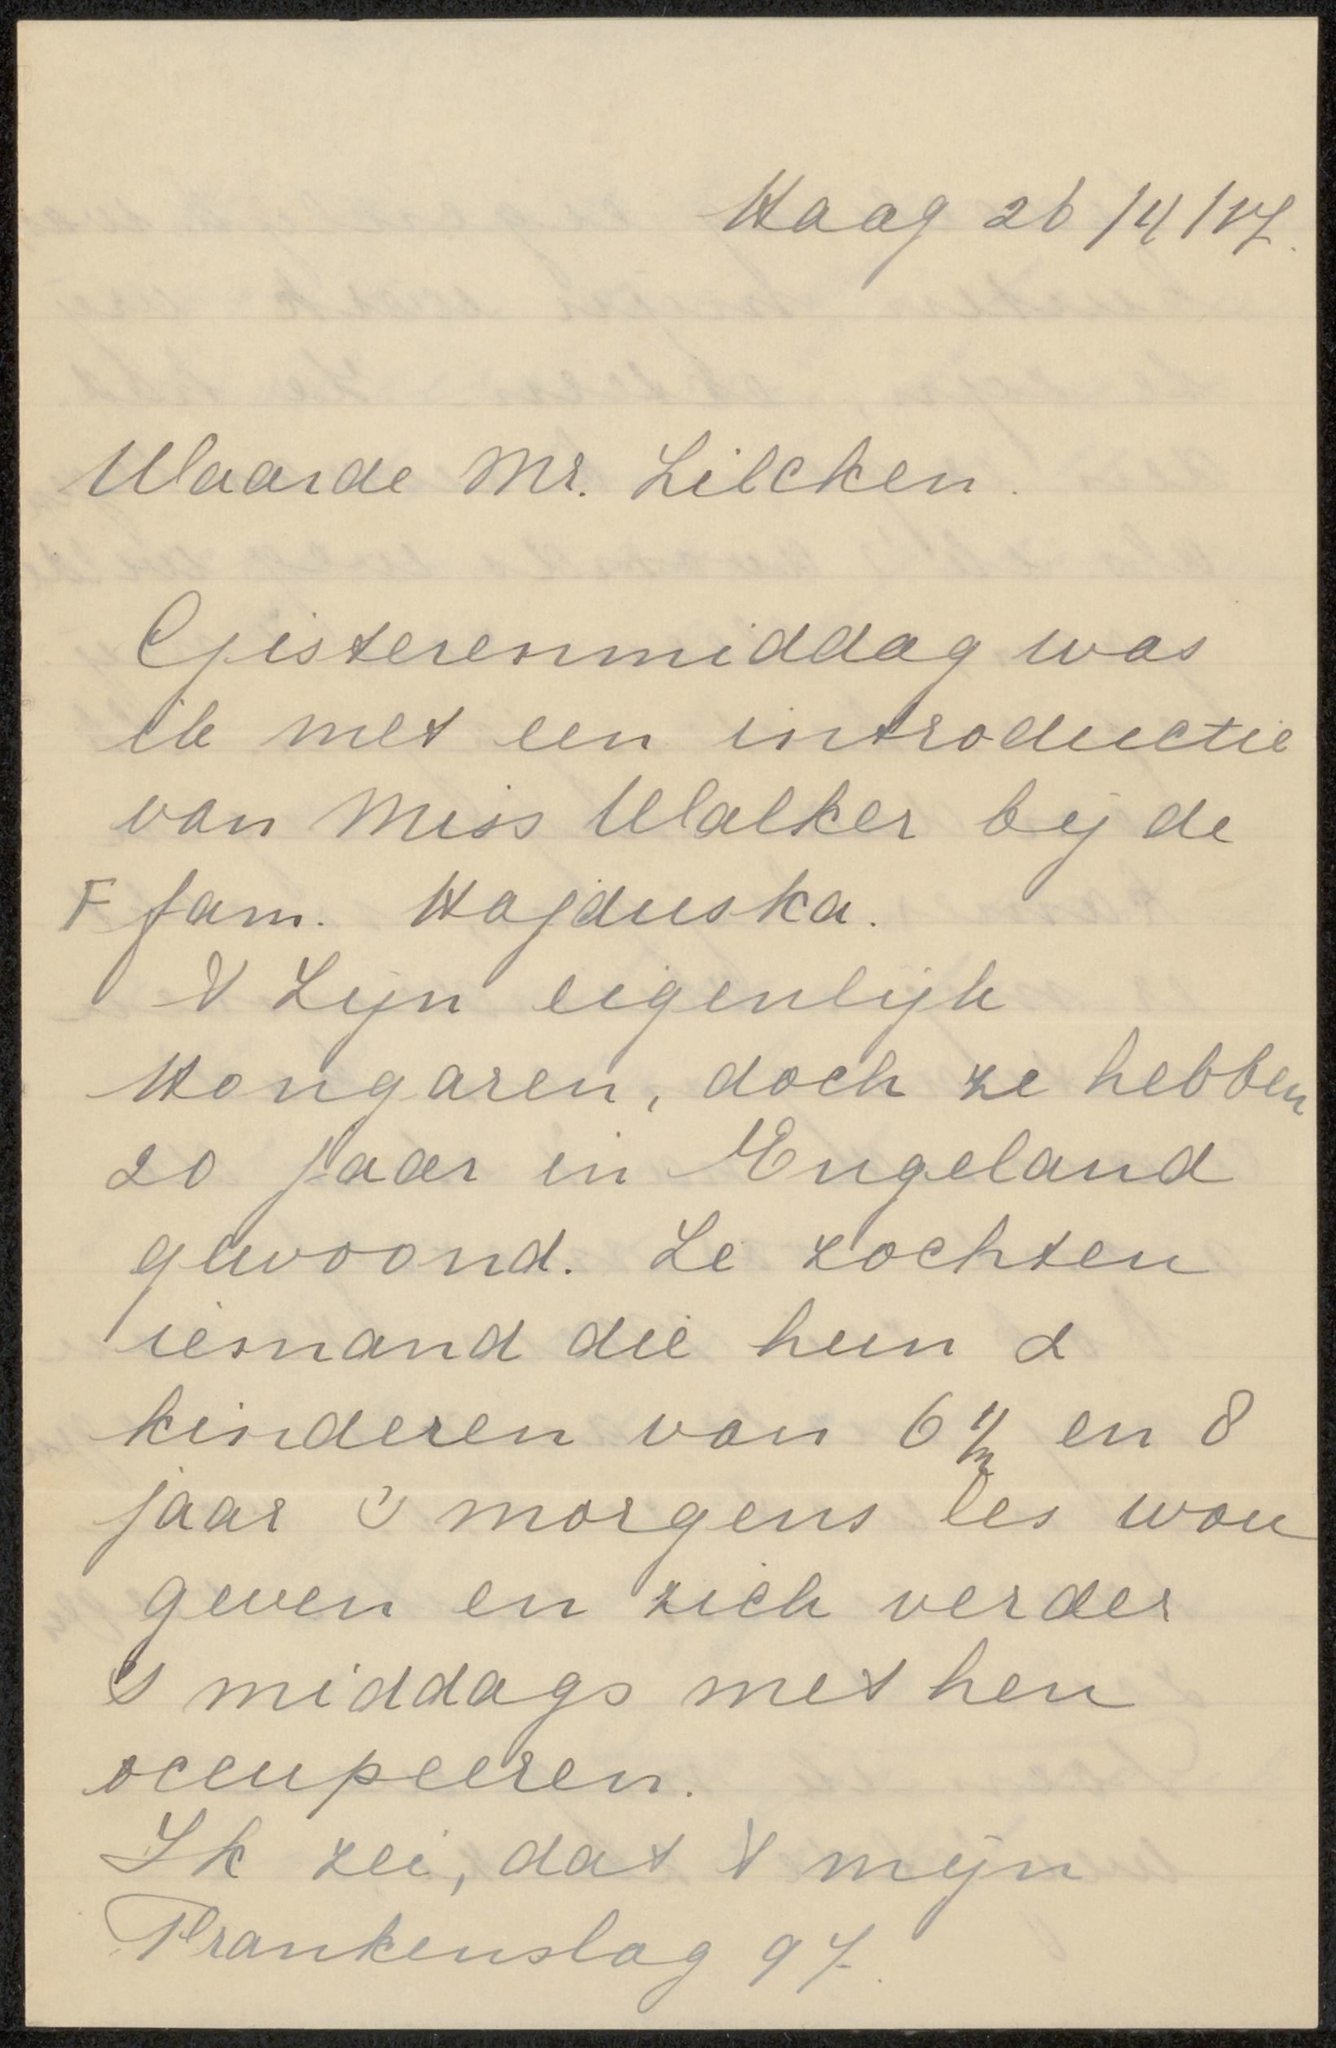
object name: letter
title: Brief aan Philip Zilcken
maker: jo geul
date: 1917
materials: ink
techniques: pen, writing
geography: the hague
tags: the hague, painter, draughtsman, philip zilcken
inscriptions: collector's mark: ‘RPK’